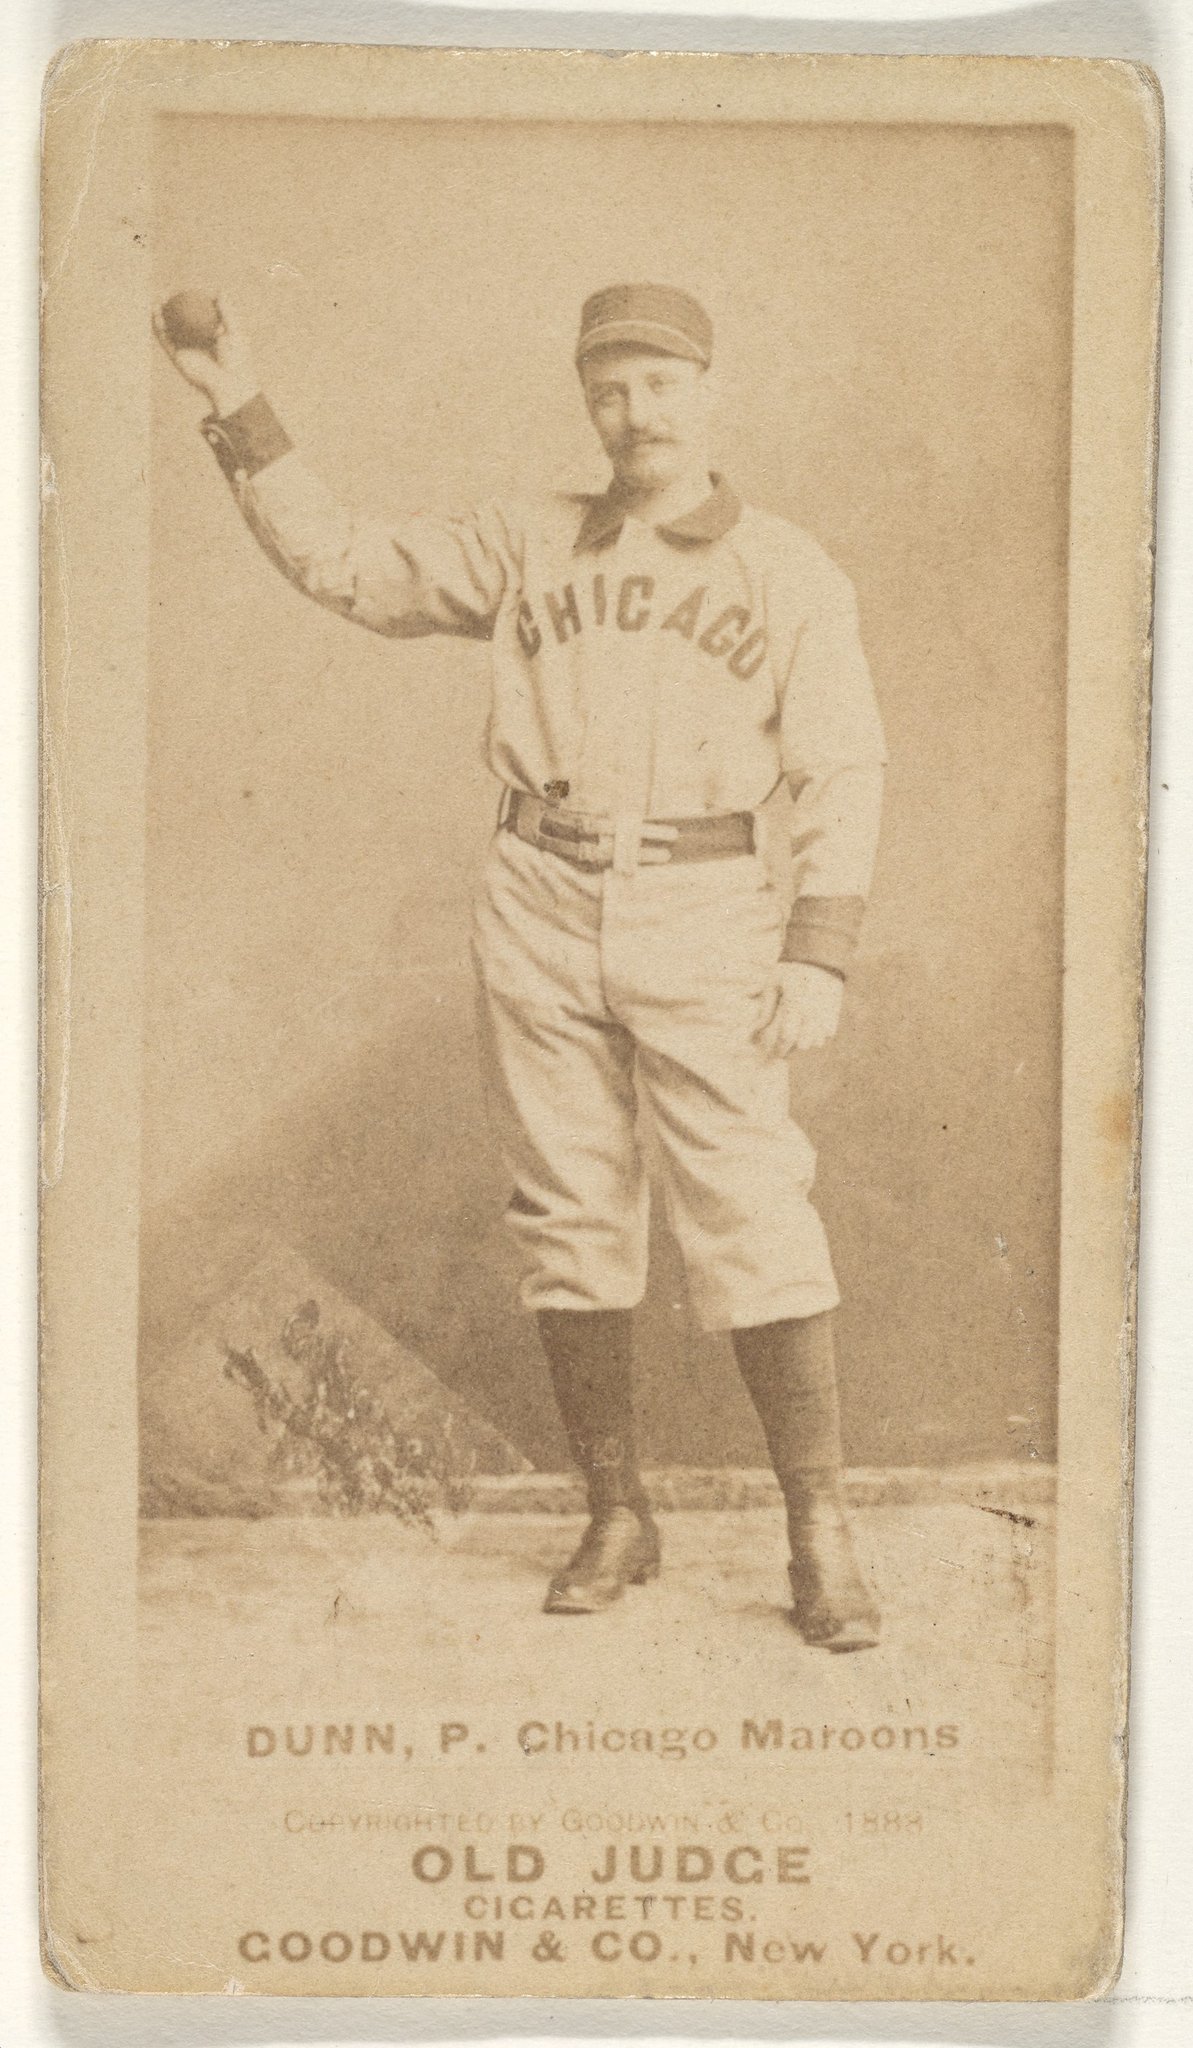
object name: baseball card, photograph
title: Dunn, Pitcher, Chicago, from the Old Judge series (N172) for Old Judge Cigarettes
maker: goodwin & company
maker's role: publisher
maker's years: 1850-1950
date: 1888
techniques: albumen silver print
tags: men,portraits,baseball,athletes